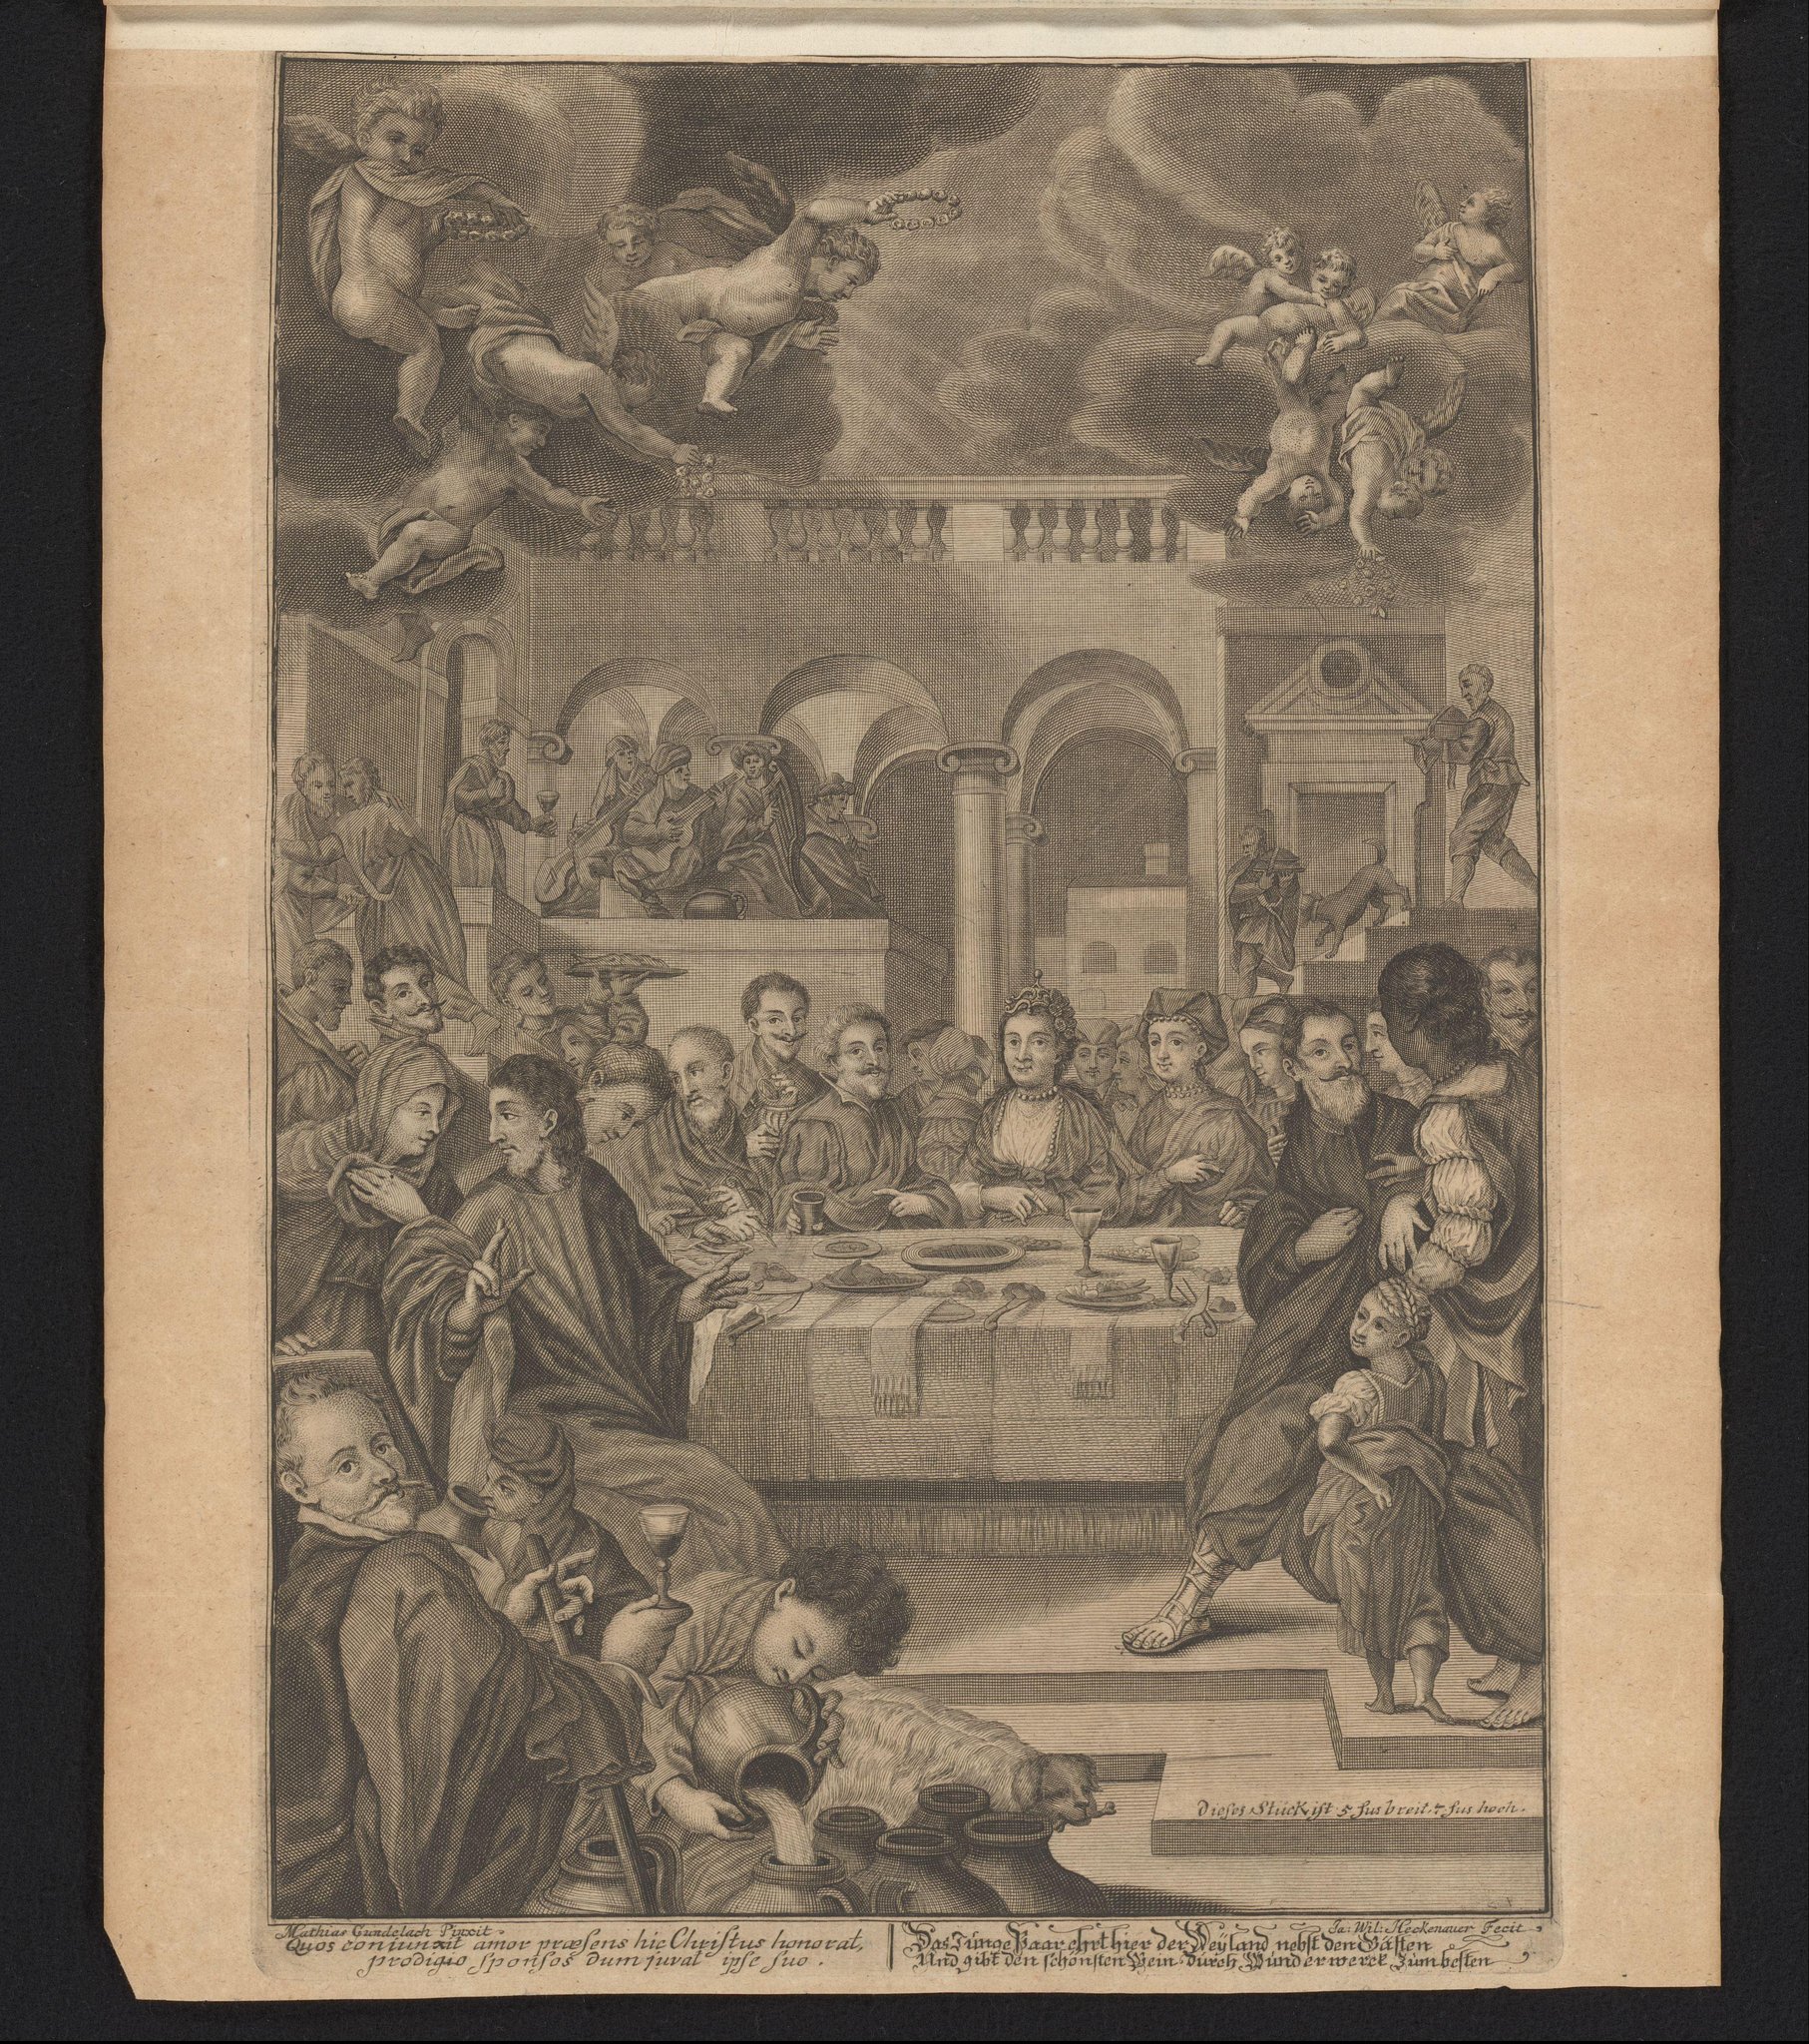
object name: print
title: Bruiloft te Kana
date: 1710-1714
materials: paper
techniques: engraving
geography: wolfenbüttel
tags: the marriage-feast at cana (john 2:1-11)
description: Tekst in het Duits en het Latijn in de ondermarge. Prent maakt deel uit van een album.